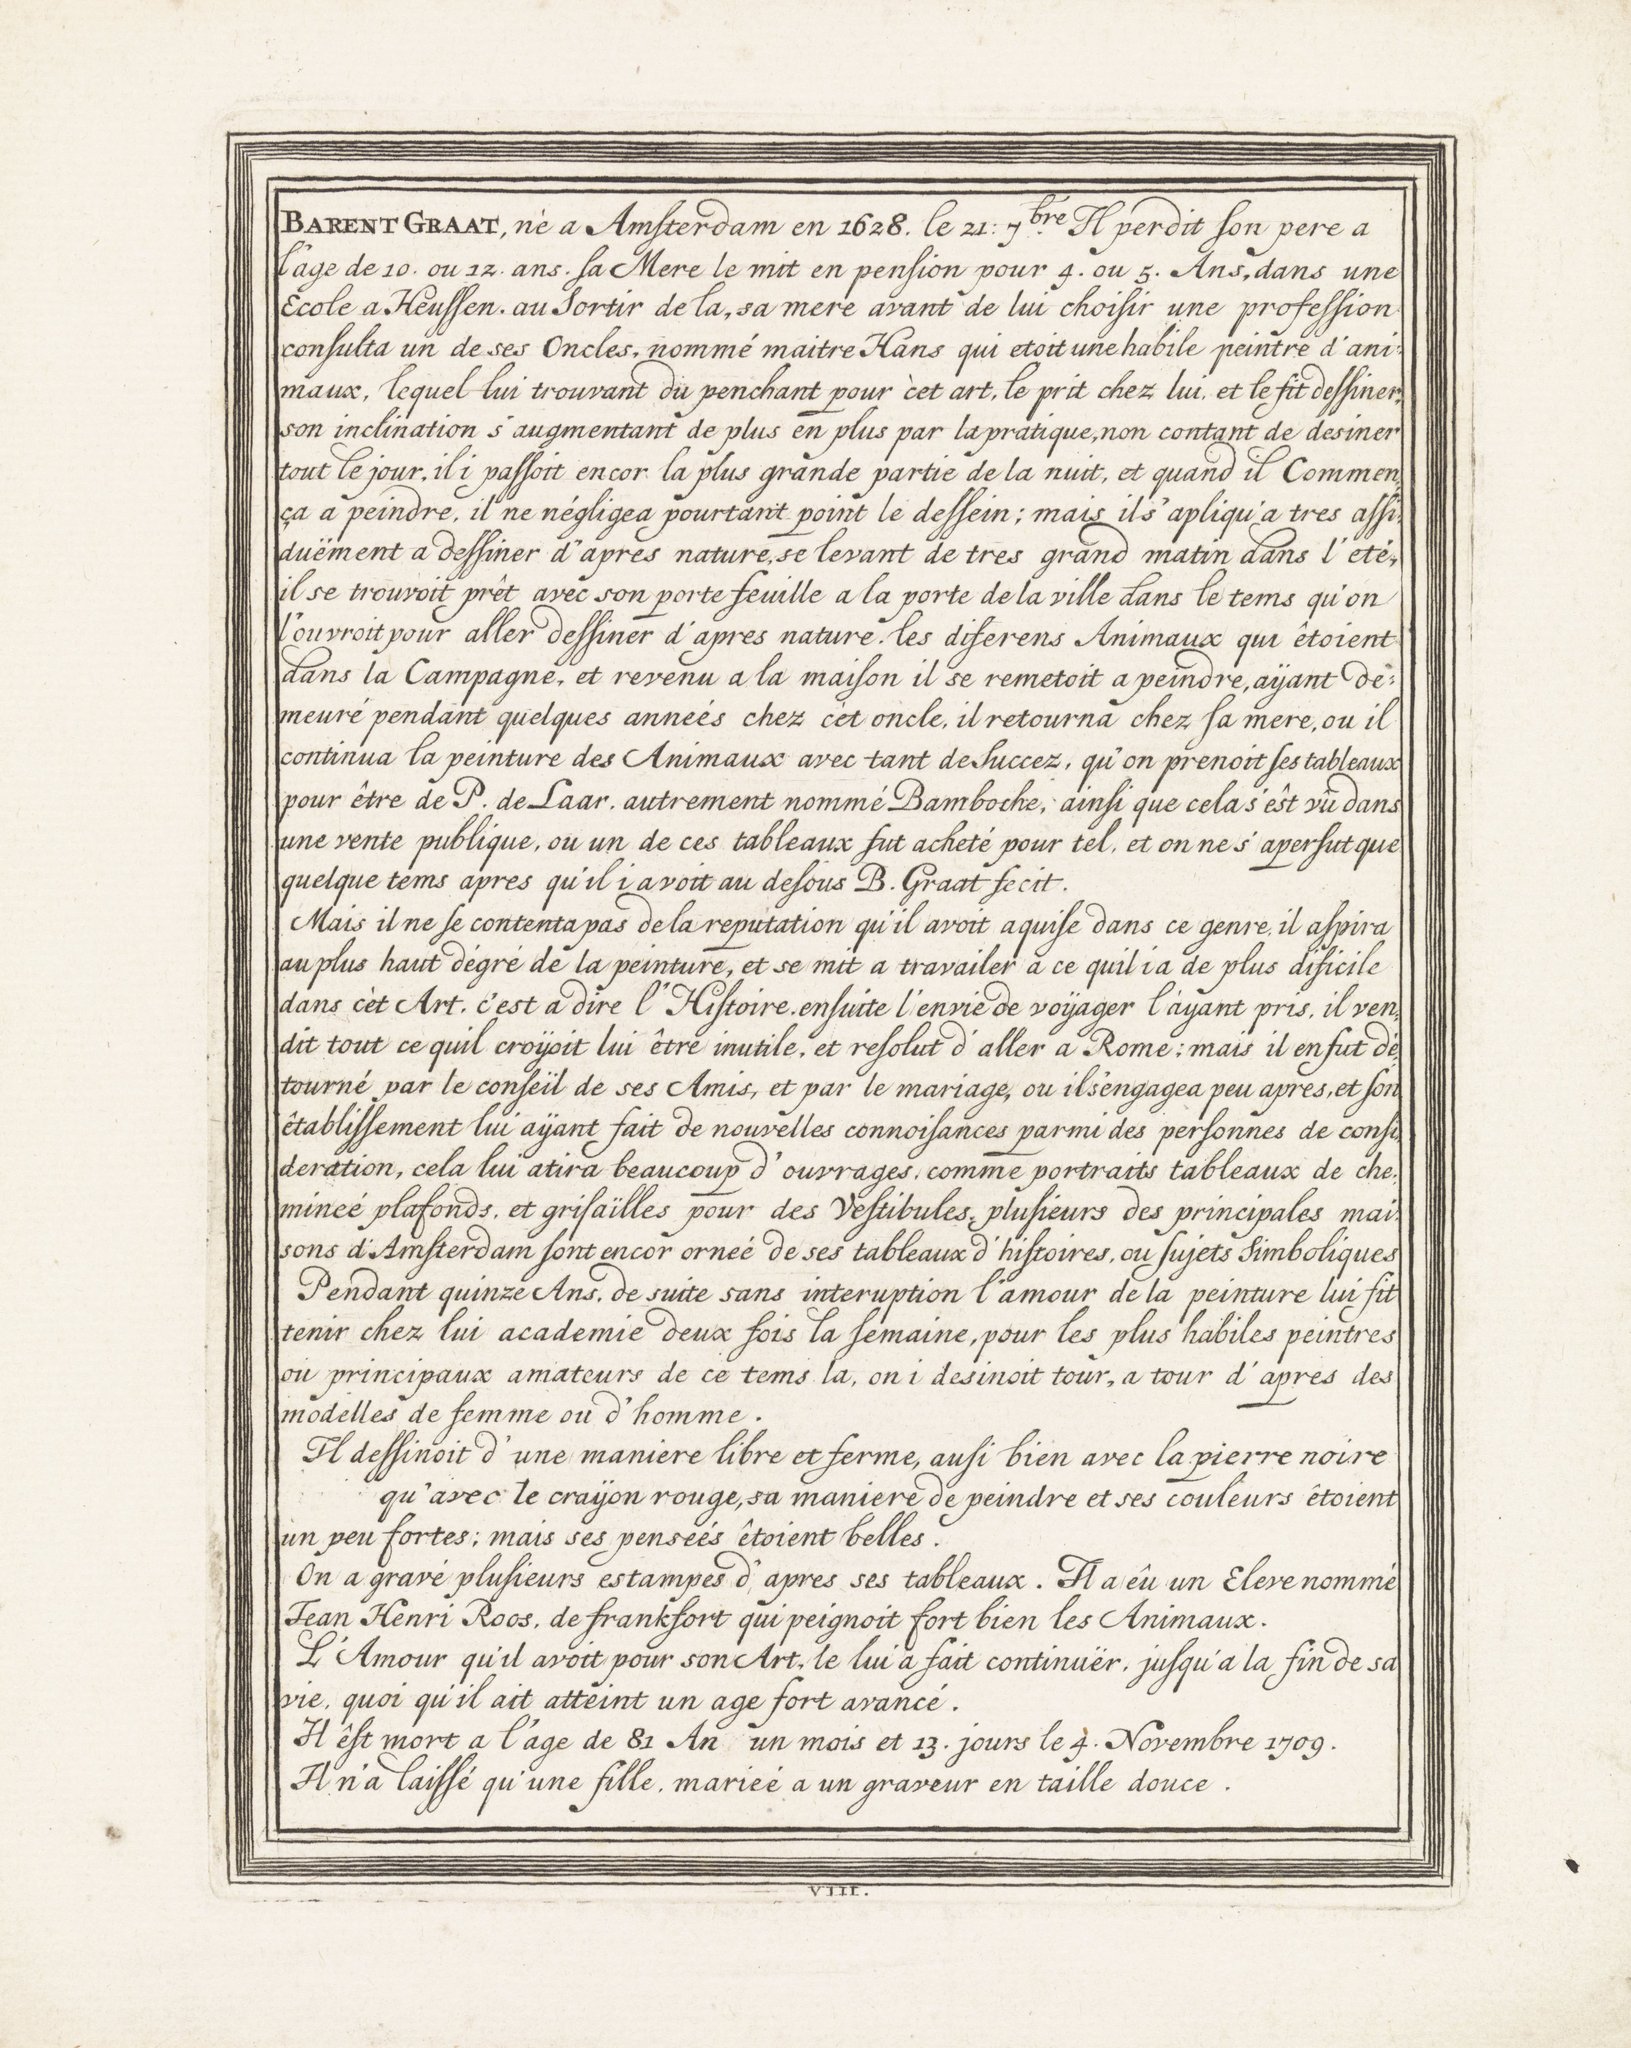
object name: text sheet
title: Biografie van kunstenaar Barend Graat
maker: matthijs pool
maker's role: print maker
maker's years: 1676-1740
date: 1727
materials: paper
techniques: etching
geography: amsterdam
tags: amsterdam, print maker, draughtsman, barend graat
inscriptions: collector's mark: Lugt 2228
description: Blad ook gebruikt in: Bossuit, Francis van. Cabinet de l'art de schulpture (...). Executé en yvoire (...). = Beeld-snyders kunst-kabinet (...). = Statues, or Art's cabinet. Amsterdam: M. Pool, 1727.